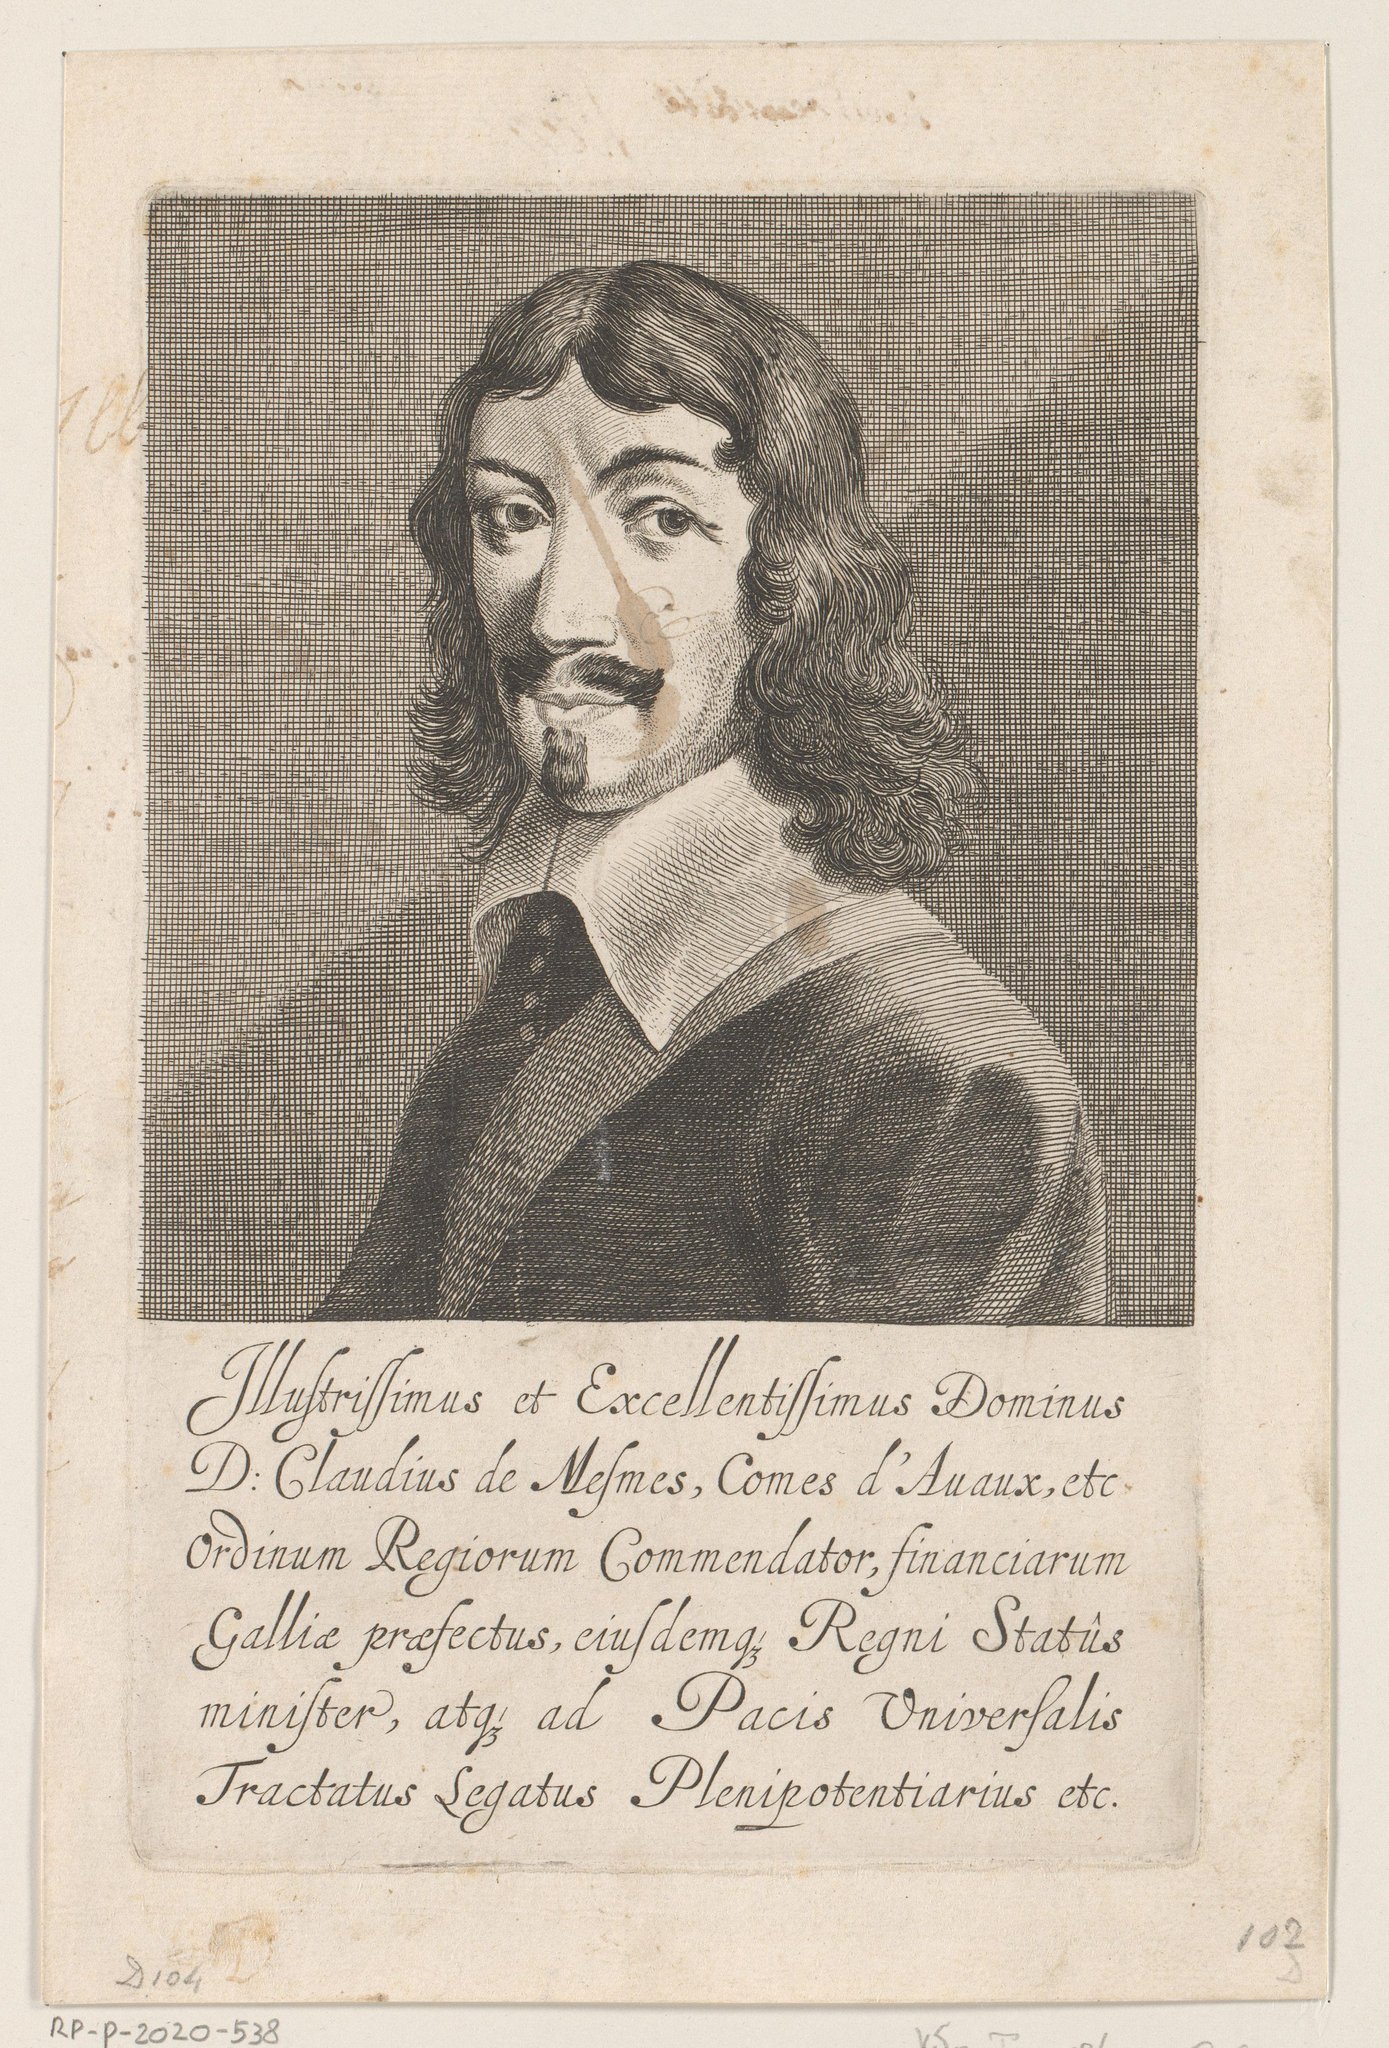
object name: print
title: Portret van diplomaat Claude de Mesmes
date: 1644-1646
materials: paper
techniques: engraving, etching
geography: amsterdam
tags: historical persons, diplomacy, diplomat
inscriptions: collector's mark: Lugt 240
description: Prent maakt deel uit van een serie van 43 prenten. Latere staat van prent gebruikt in de serie 'Pacificatores orbis Christiani in Westphaliam missi anno 1641', uitgegeven door Rombout van den Hoeye in Amsterdam.